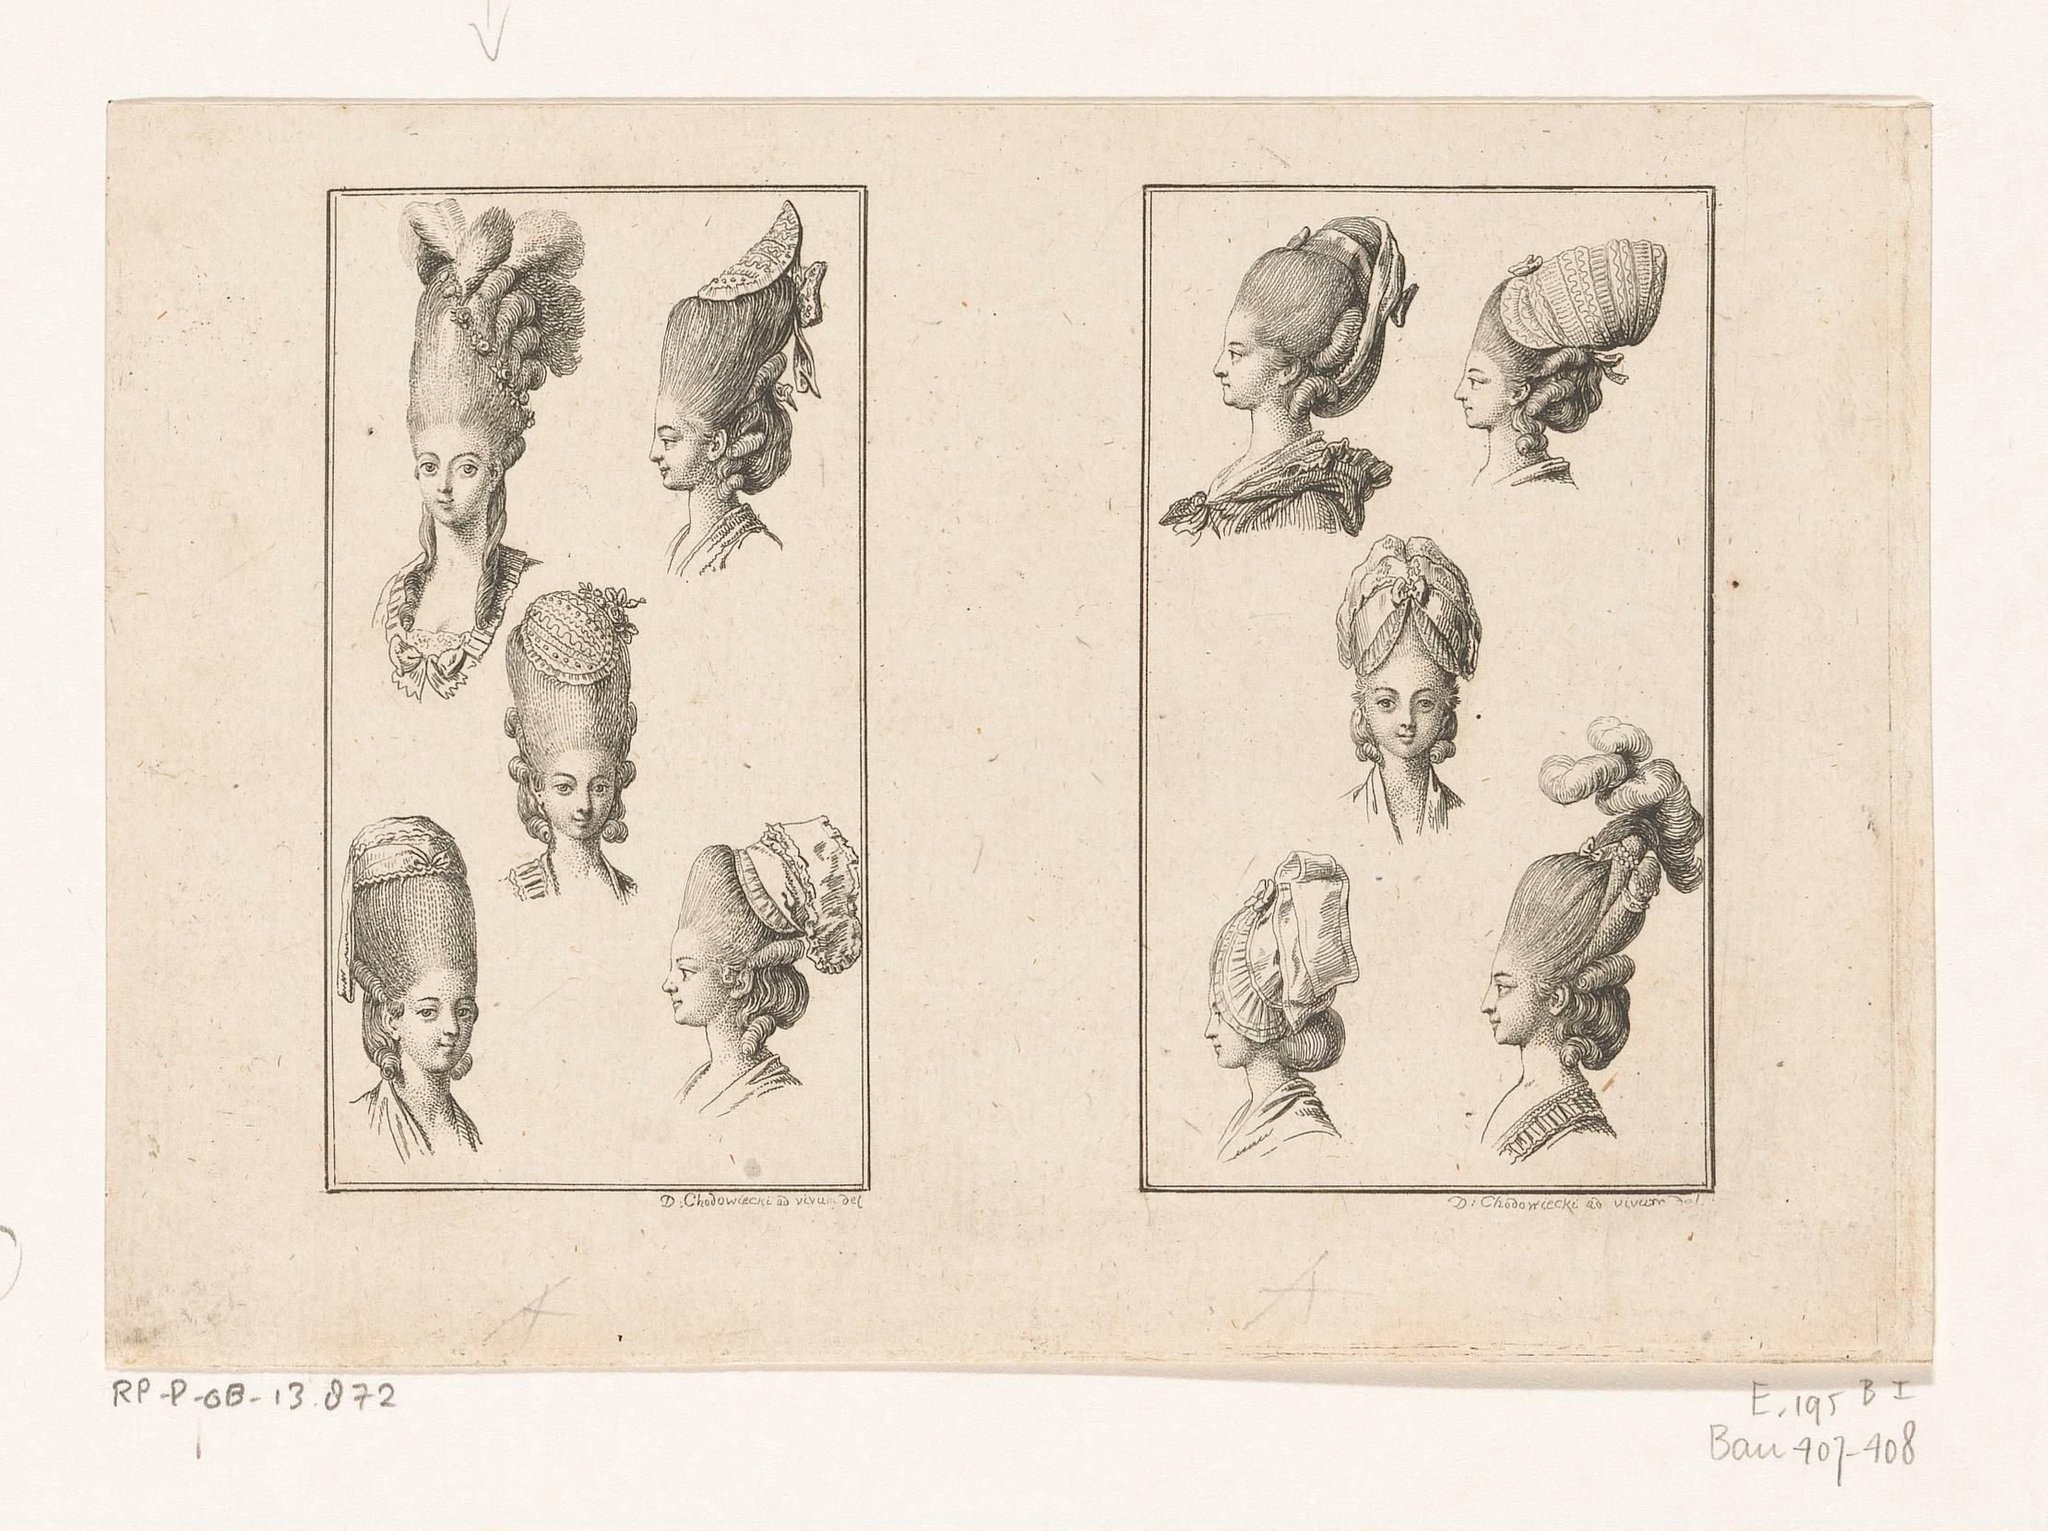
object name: fashion print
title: Berlijnse dameskapsels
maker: daniel nikolaus chodowiecki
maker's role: draughtsman, print maker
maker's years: 1726-1801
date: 1777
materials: paper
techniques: etching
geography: berlin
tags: styles of hairdress (herisson) - aa - ~ women, head-gear (+ women's clothes), styles of hairdress - aa - ~ women, head-gear: cap (+ women's clothes), head-gear (bonnet) (+ women's clothes)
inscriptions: collector's mark: Lugt 2228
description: Vijf verschillende dameskapsels en hoofdbedekkingen uit Berlijn, 1777. Uit de Göttinger Taschen-Calender voor 1778. Exemplaren RPK zonder nummers en onderschrift. In de tweede staat zijn de vrouwenhoofden genummerd en worden onder de voorstelling de namen van de kapsels genoemd. Van boven naar onderen: Herisson, petit bonnet, demi ajusté; Dormeuse, Parure.